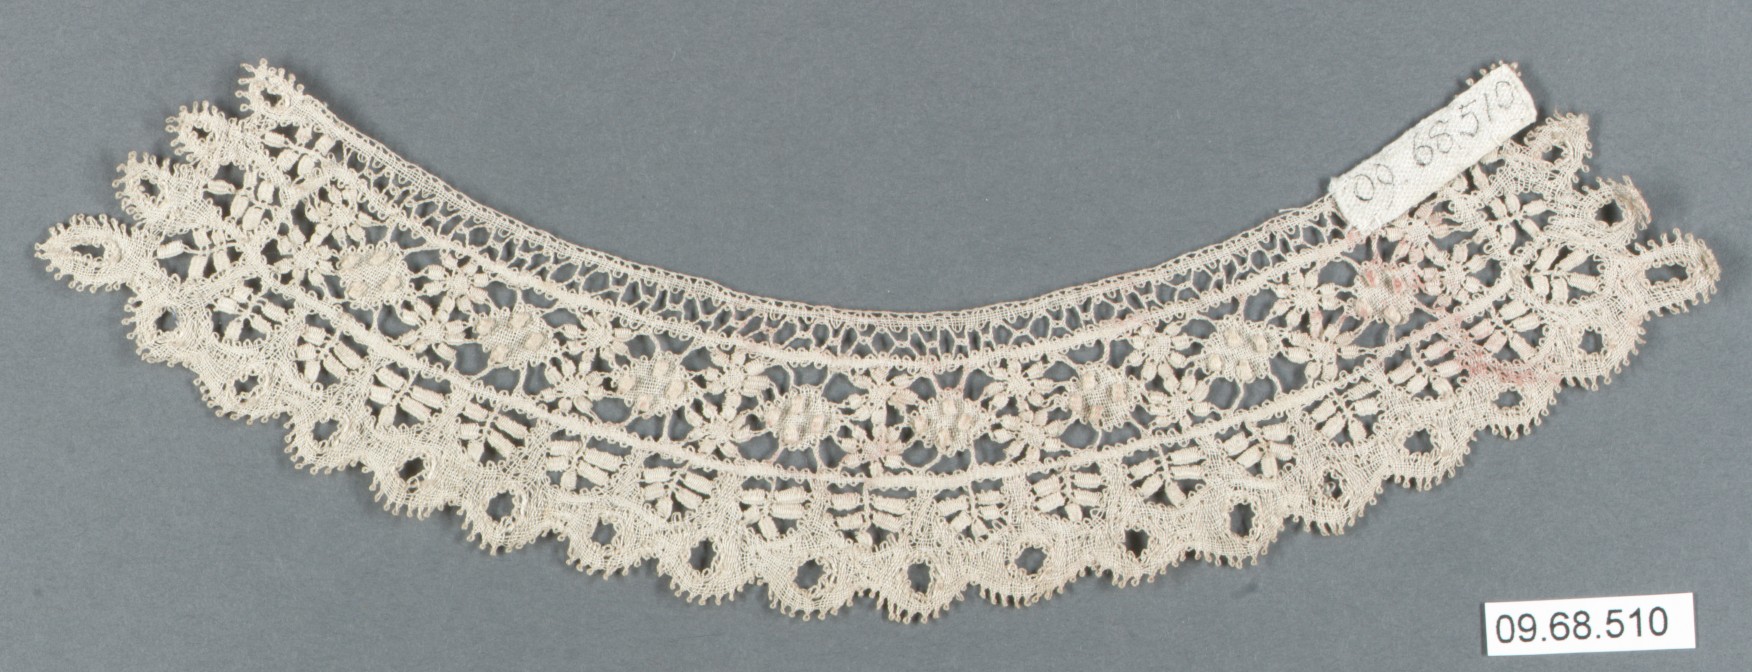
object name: cuff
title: Lace cuffs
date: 1801-1900